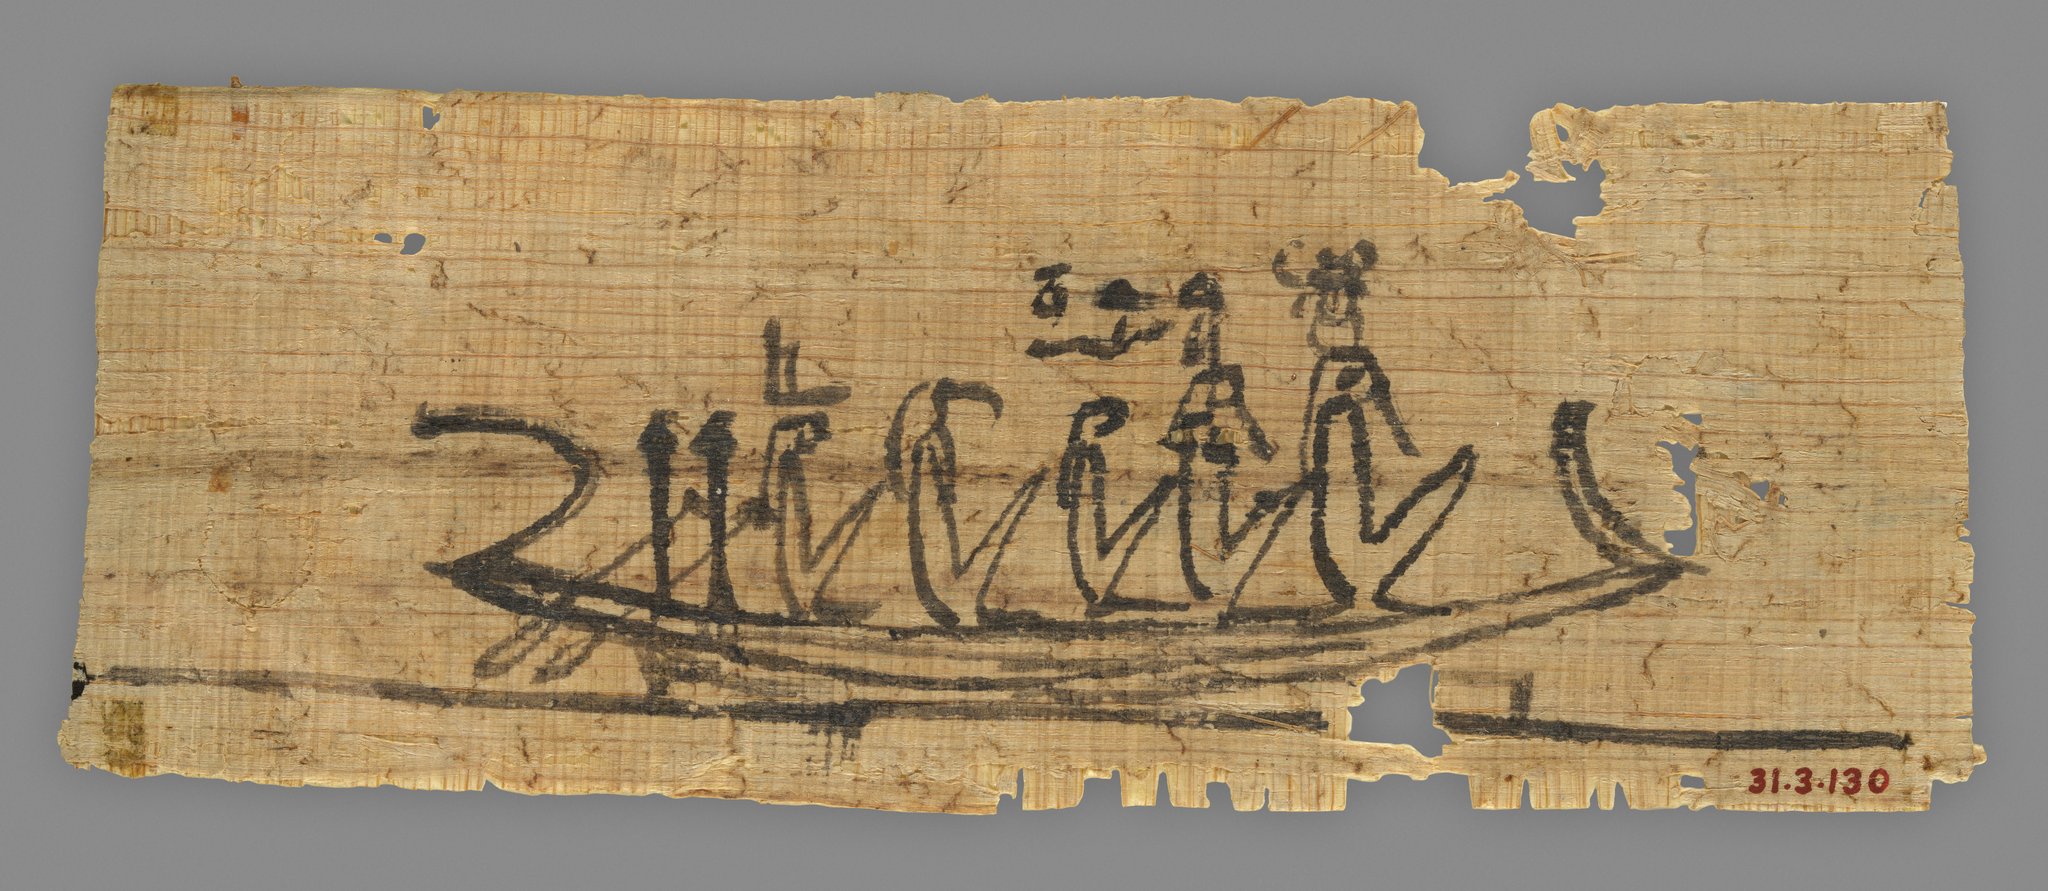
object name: papyrus, funerary, deity, god, boat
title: Papyrus fragment with a painting of Khepri, Shu, Tefnut, Thoth, and Isis in a solar boat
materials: ink, papyrus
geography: egypt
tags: boats